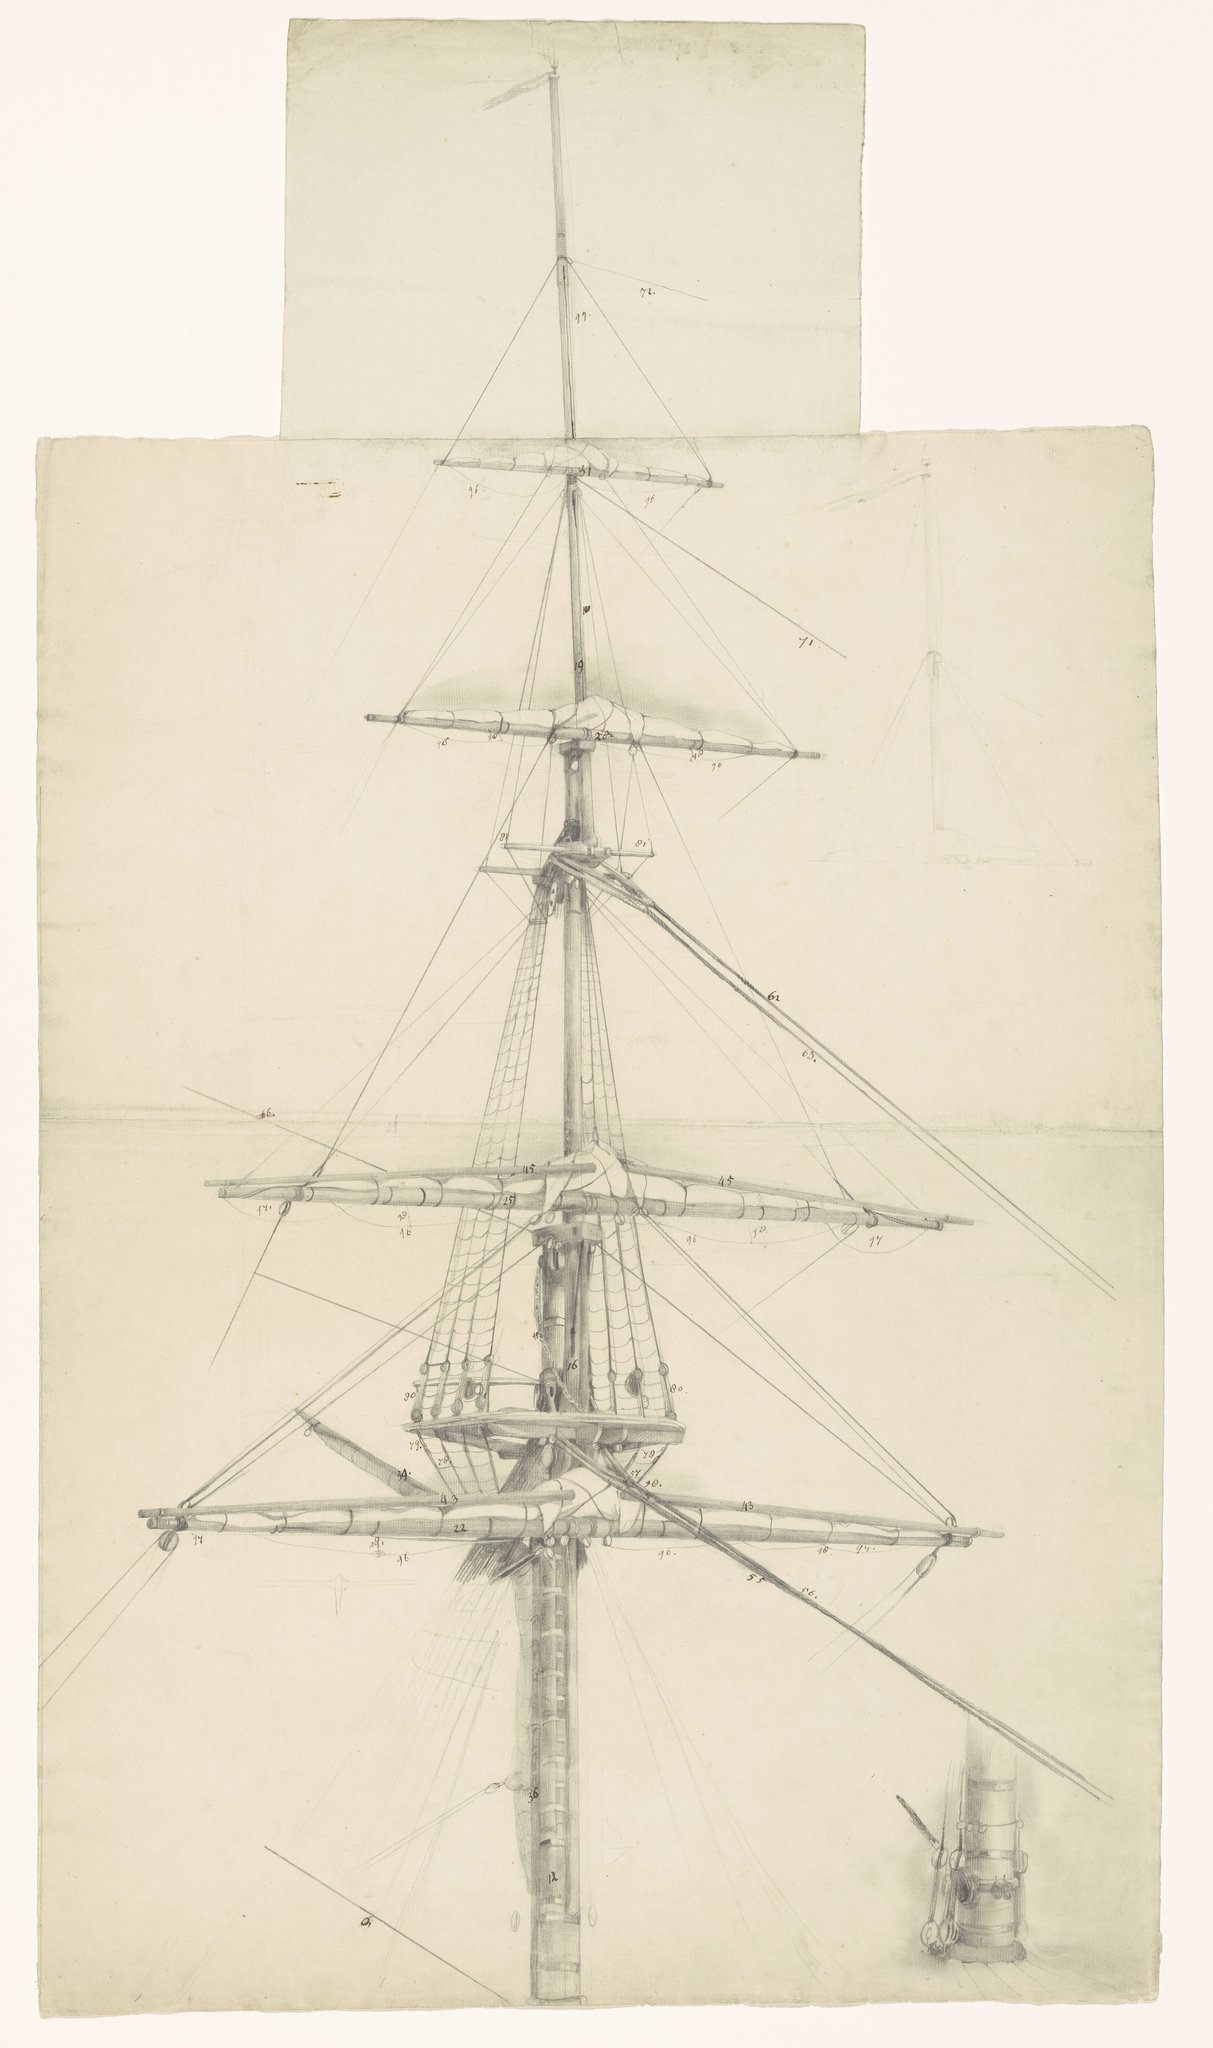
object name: drawing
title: Mast van een zeilschip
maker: willem anthonie van deventer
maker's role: draughtsman, painter, print maker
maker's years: 1824-1893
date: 1834-1893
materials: ink, paper, pencil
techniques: pen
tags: sailing-ship's rigging, parts of ship's exterior: mast